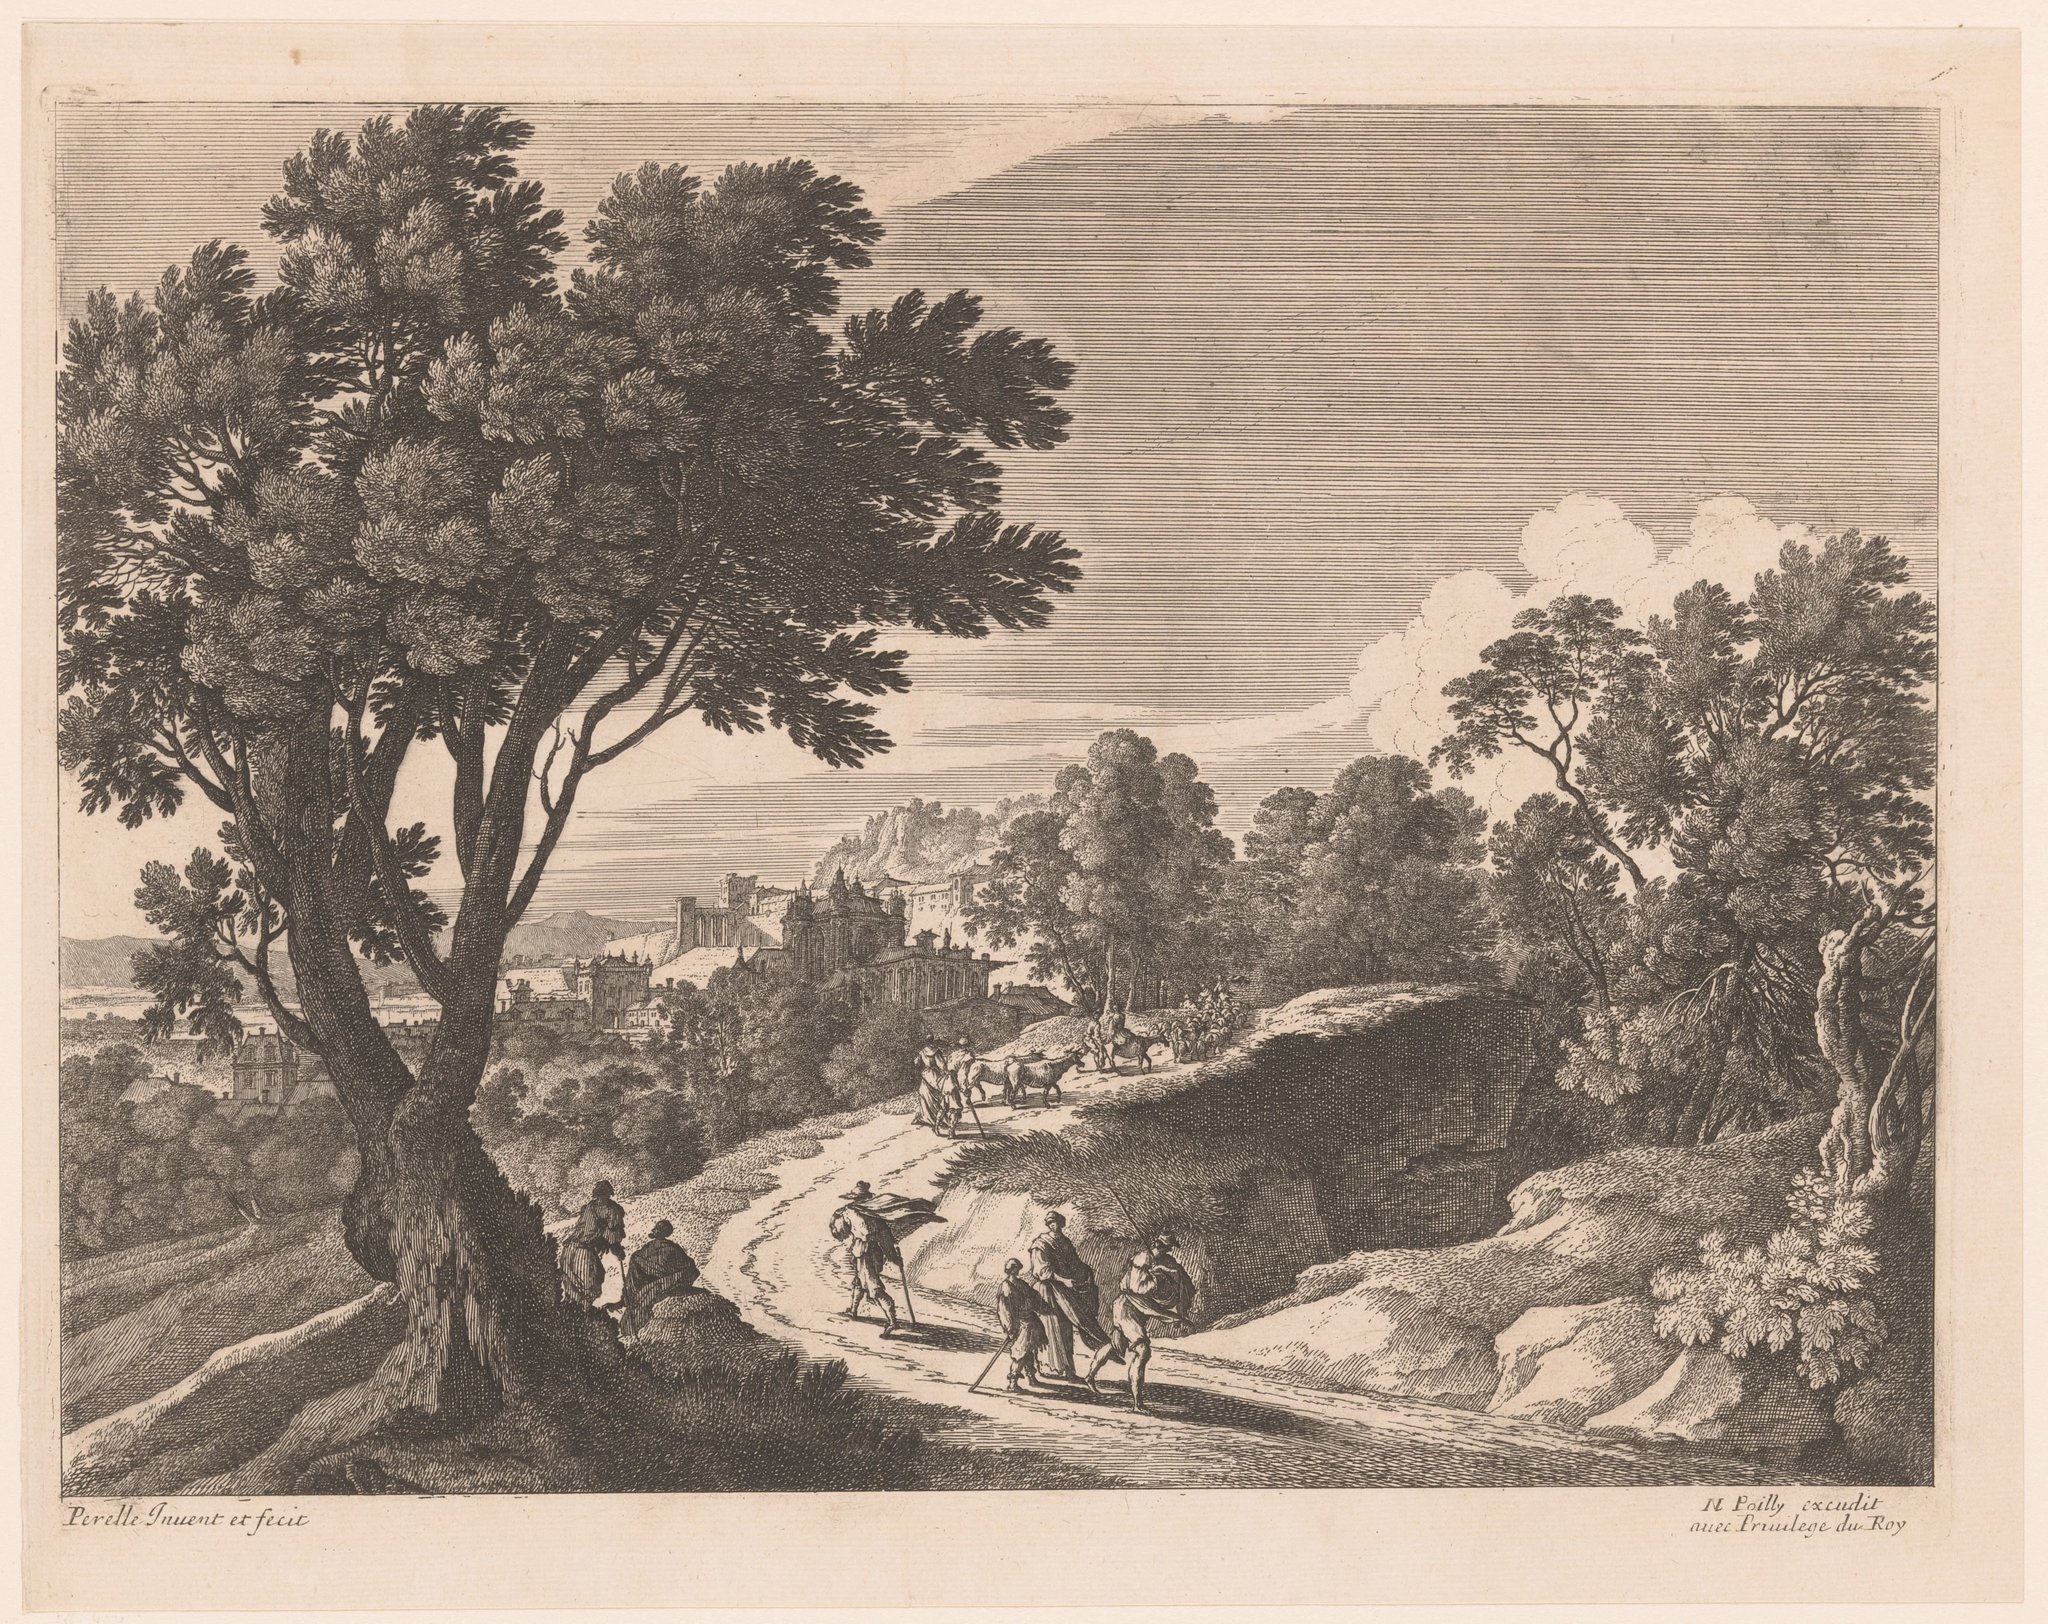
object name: print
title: Landweg buiten een stad met figuren en vee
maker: nicolas de poilly (i)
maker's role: print maker, publisher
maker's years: 1626-1696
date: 1636-1696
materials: paper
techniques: engraving, etching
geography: france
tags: road, path, herd, flock, prospect of city, town panorama, silhouette of city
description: Prenten met het signatuur 'Perelle' kunnen zowel door vader Gabriel als door zonen Nicolas en Adam gemaakt zijn.